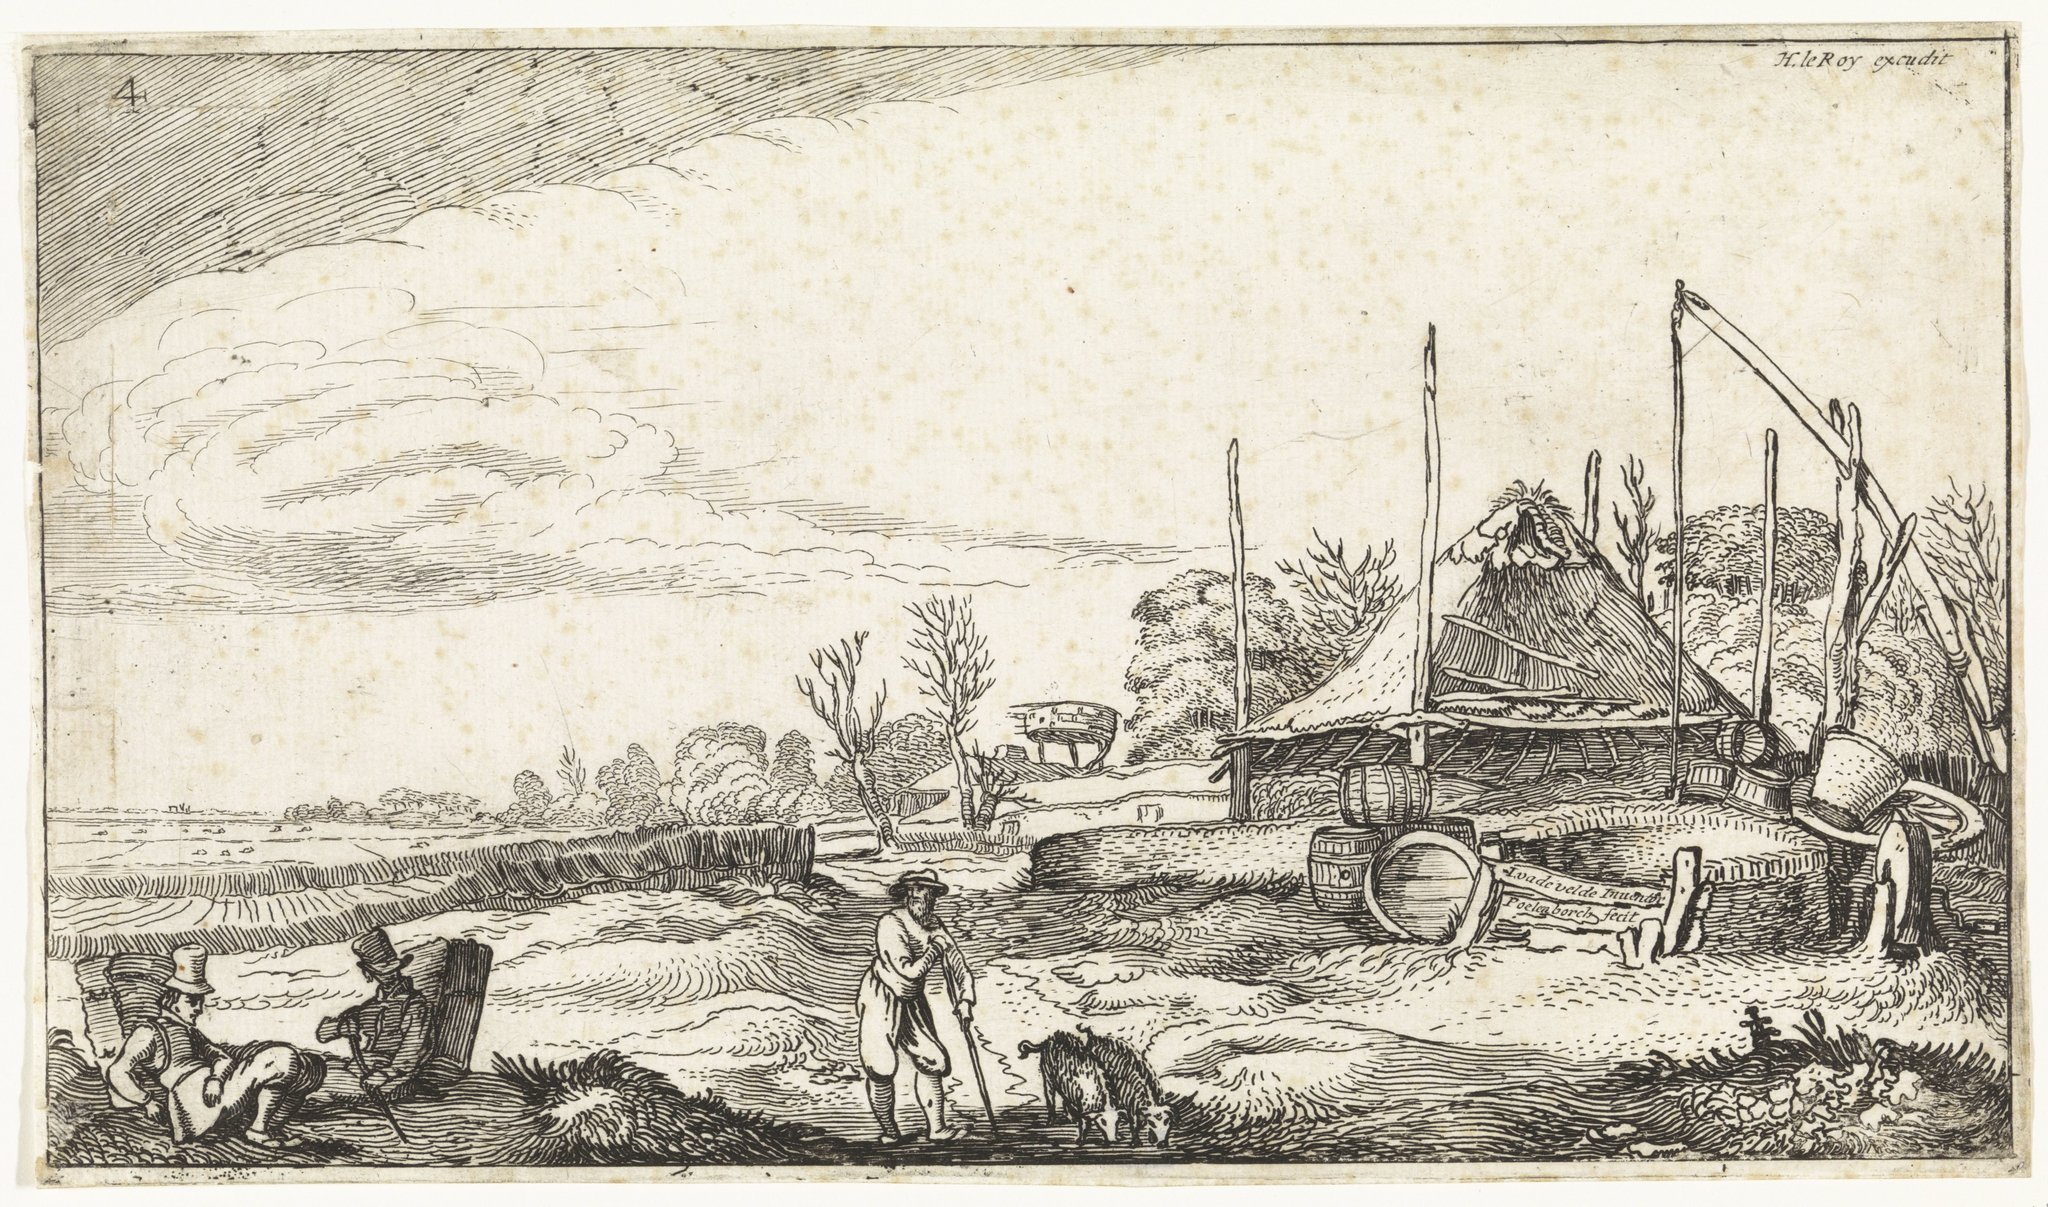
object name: print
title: Landschap met rustende marskramers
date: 1602-1649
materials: paper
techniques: etching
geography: amsterdam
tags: well, rural housing, e.g. country-house, villa, cottage, pedlar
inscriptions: collector's mark: Lugt 2228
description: Twee marskramers zitten op de grond, hun mars nog op hun rug. Een boer met twee schapen kijkt toe. Op de achtergrond een rietgedekte boerderij met een grote waterput ervoor. Genummerd als 4.